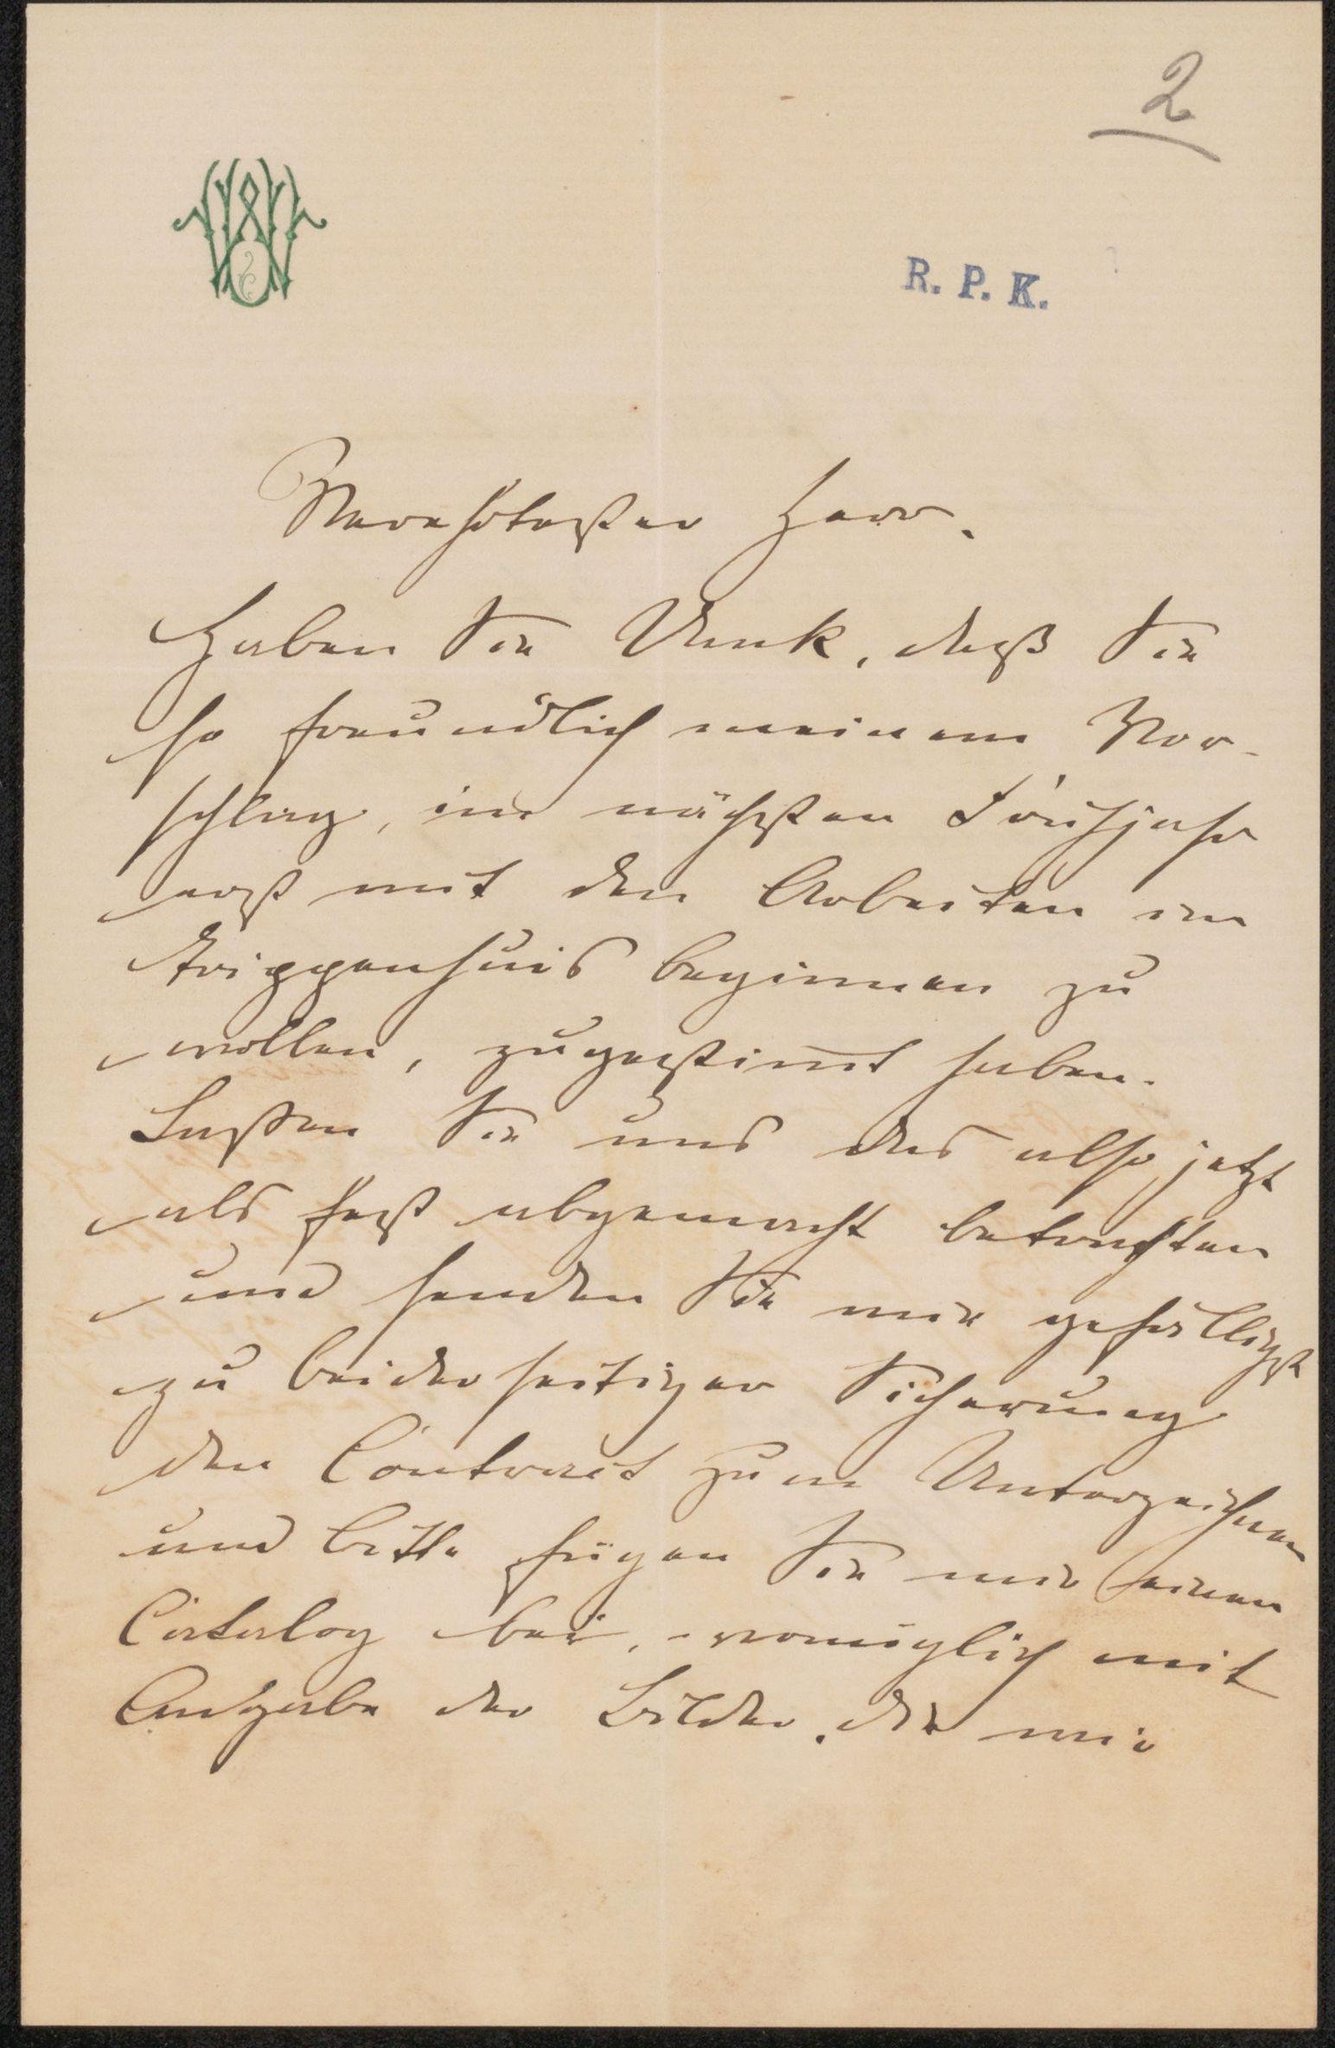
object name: letter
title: Brief aan Frans Buffa en Zonen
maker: william unger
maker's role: draughtsman, painter, print maker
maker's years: 1837-1932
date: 1873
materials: ink, paper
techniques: pen, printing, writing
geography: gutenstein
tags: publisher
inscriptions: collector's mark: Lugt 2233